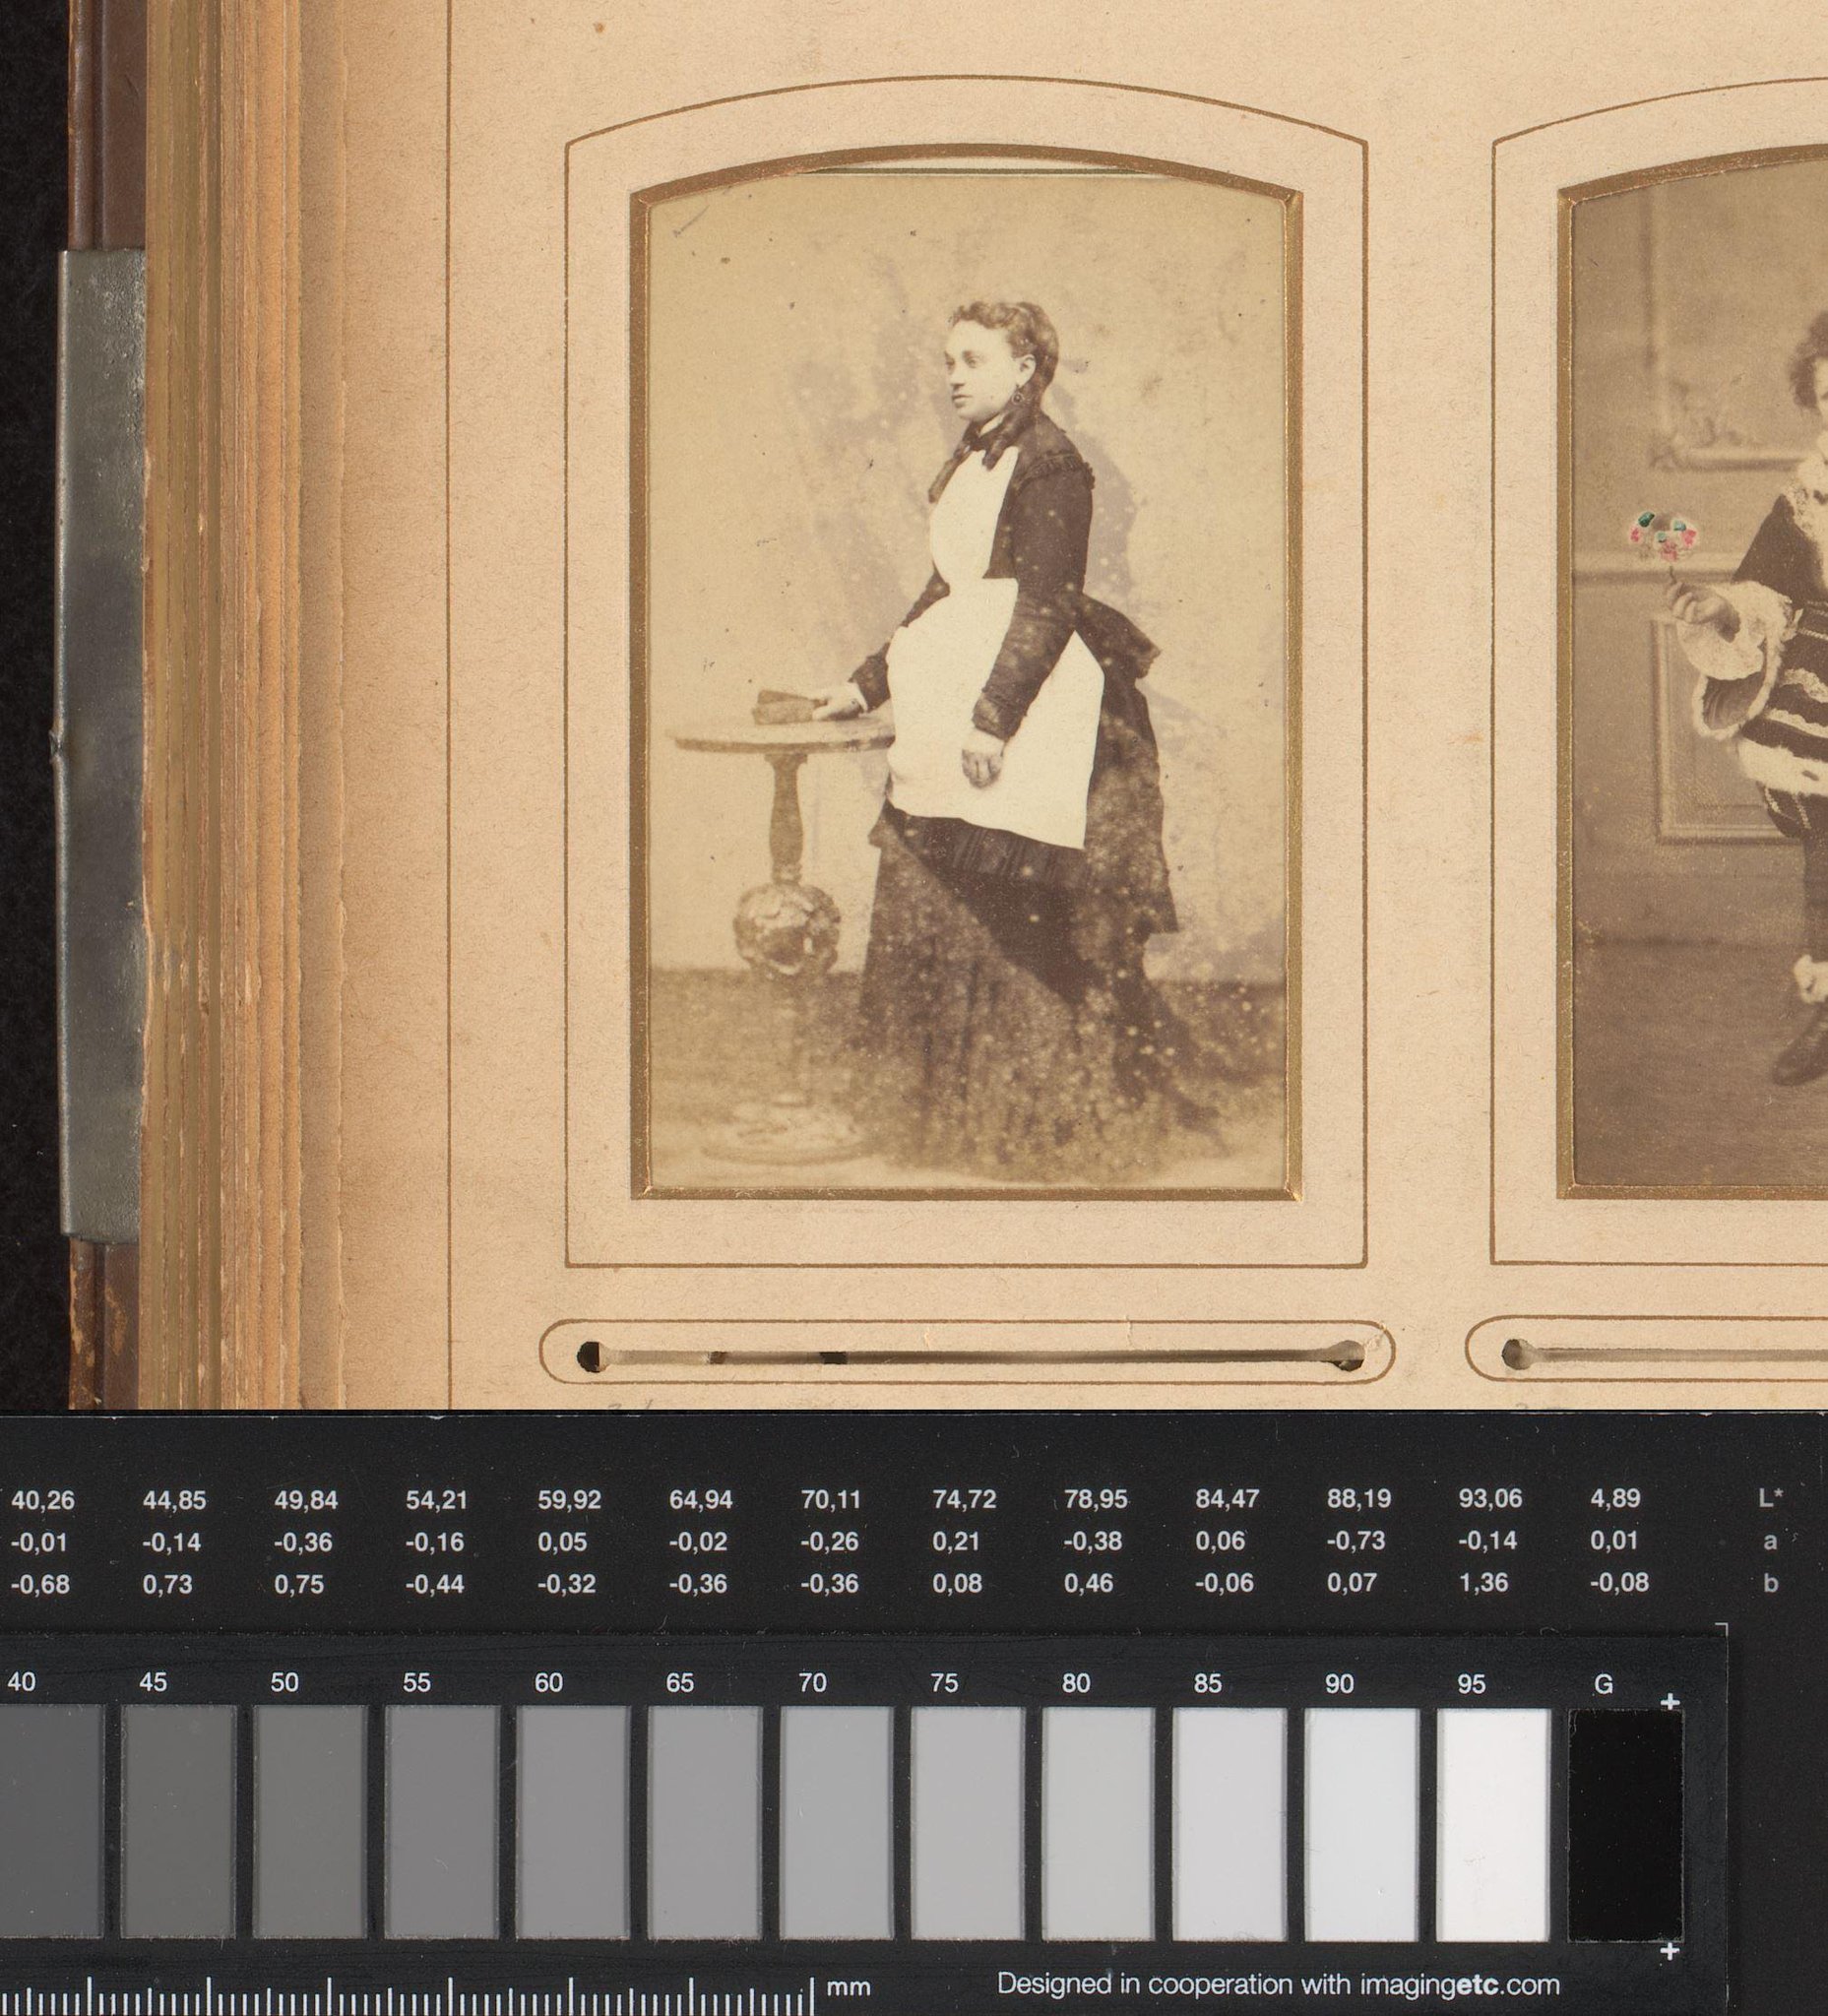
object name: photograph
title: Portret van een onbekende vrouw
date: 1880-1884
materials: cardboard, paper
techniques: albumen print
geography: amsterdam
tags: anonymous historical person portrayed - bb - woman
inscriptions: address: ‘Kalverstraat D.26/ AMSTERDAM/ Leijdschestraatweg buiten Cathrijnen/ UTRECHT’